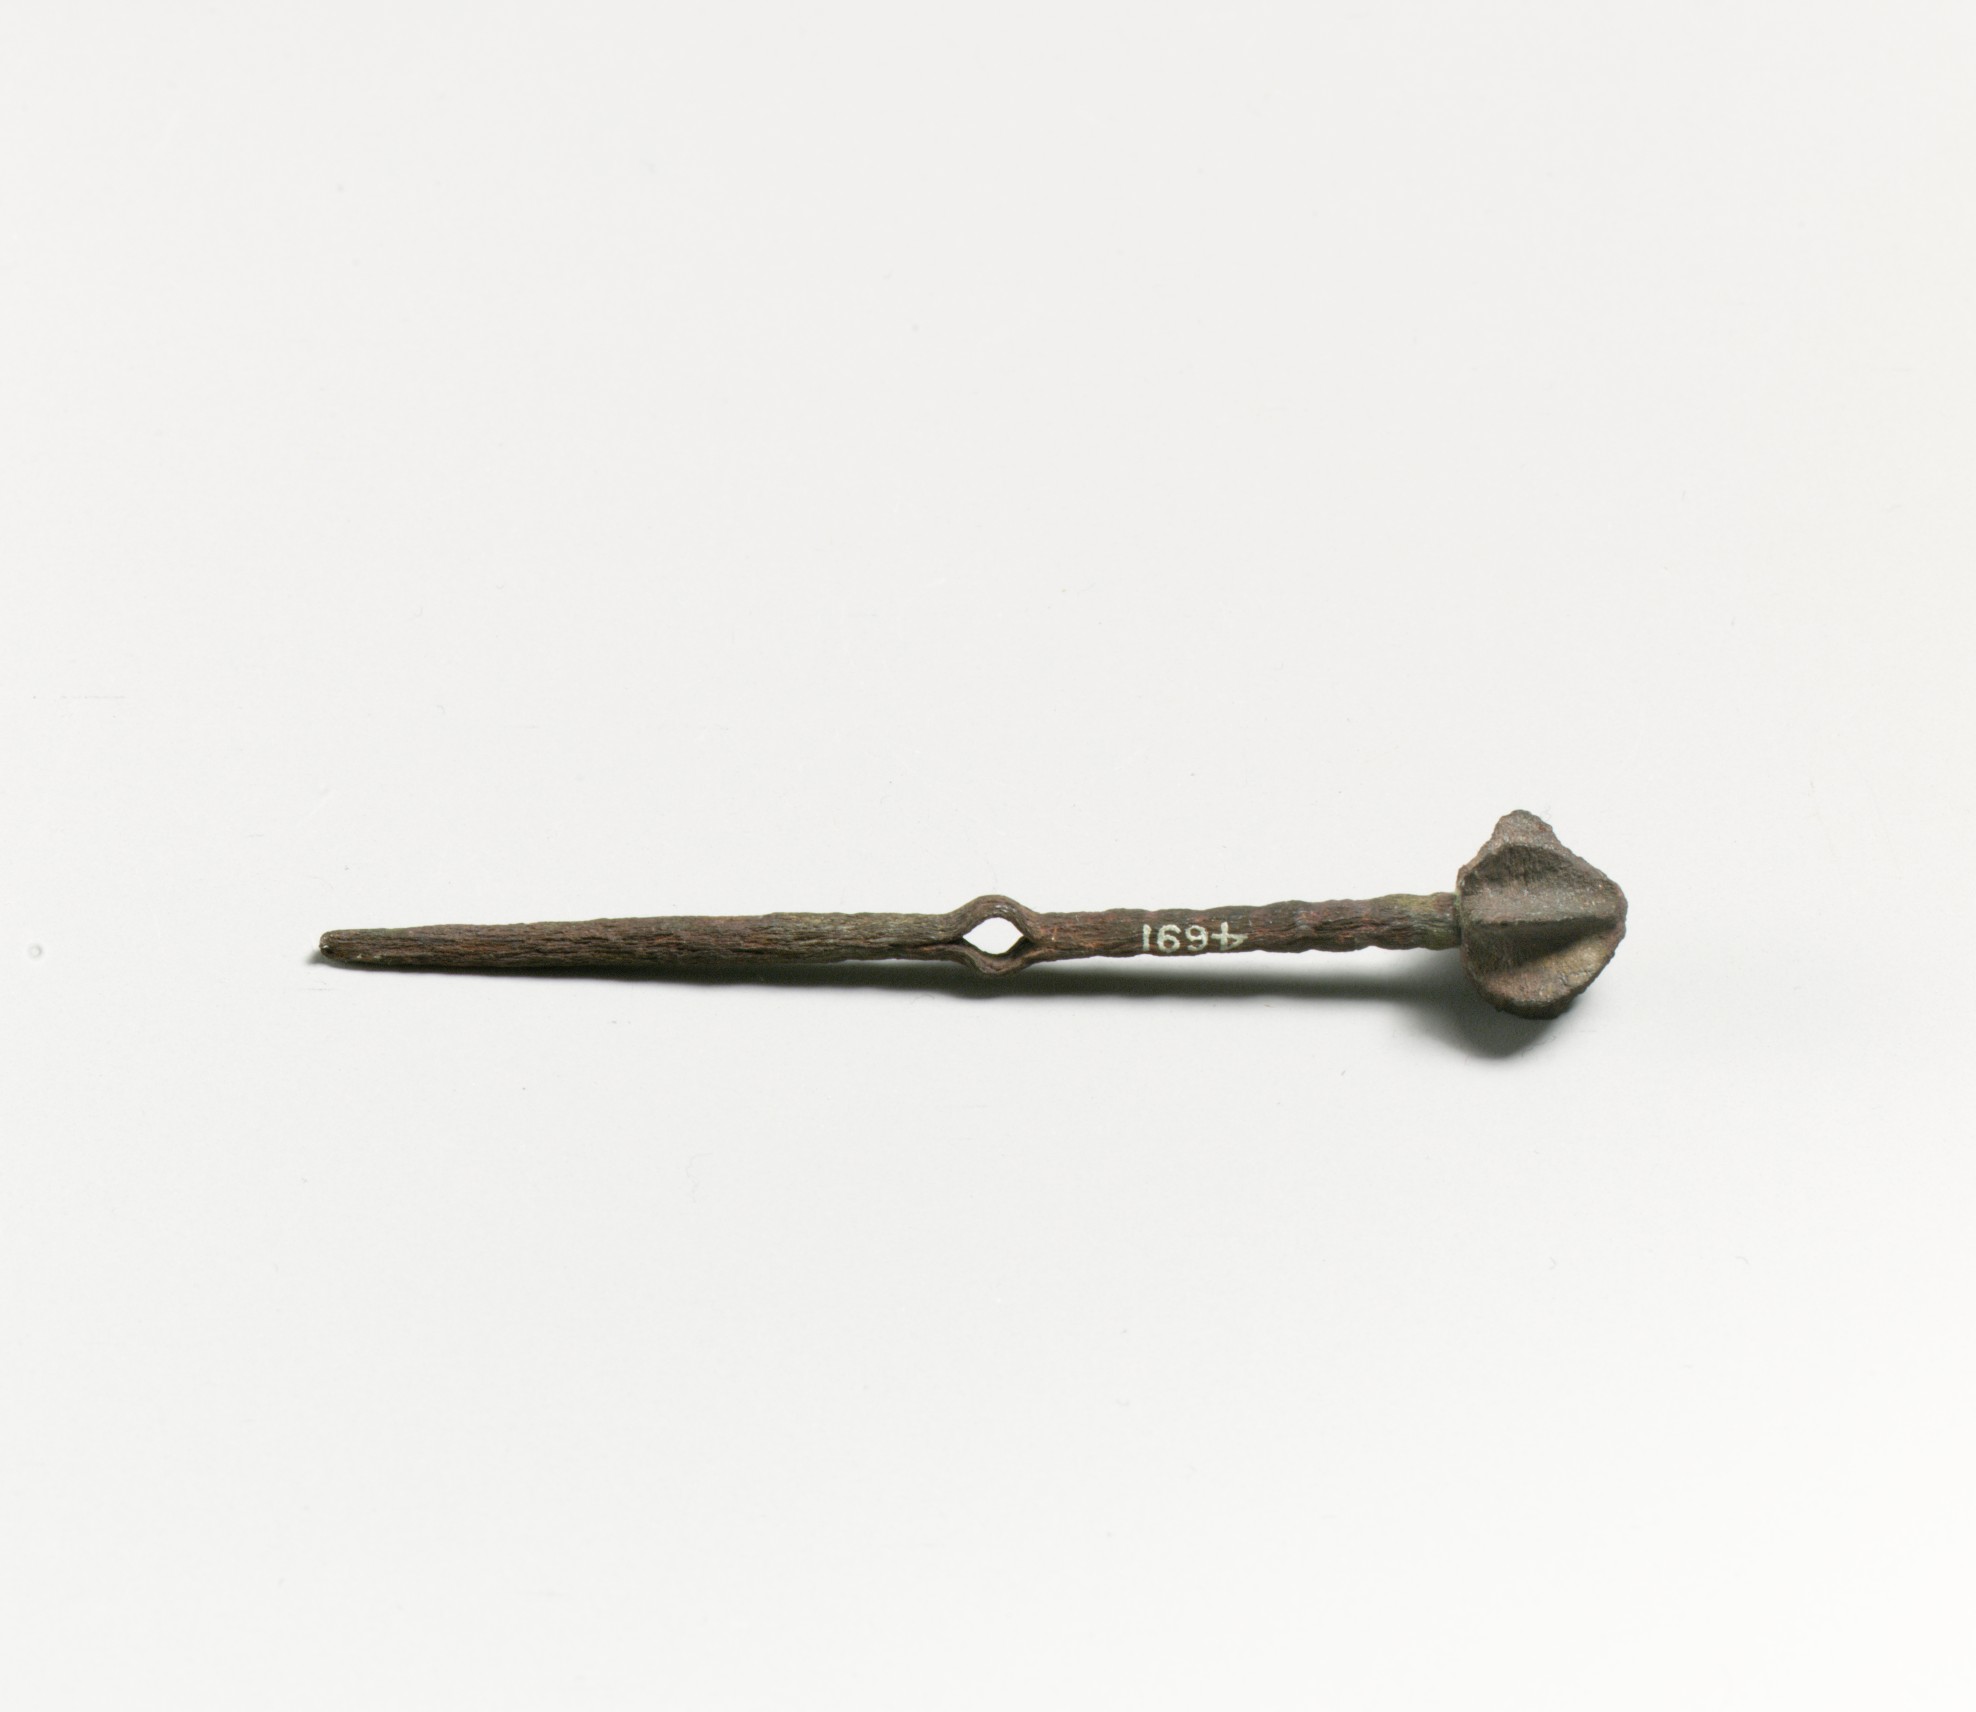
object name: pin, eyelet type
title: Bronze eyelet-type pin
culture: mycenaean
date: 1400-1301 BCE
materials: bronze